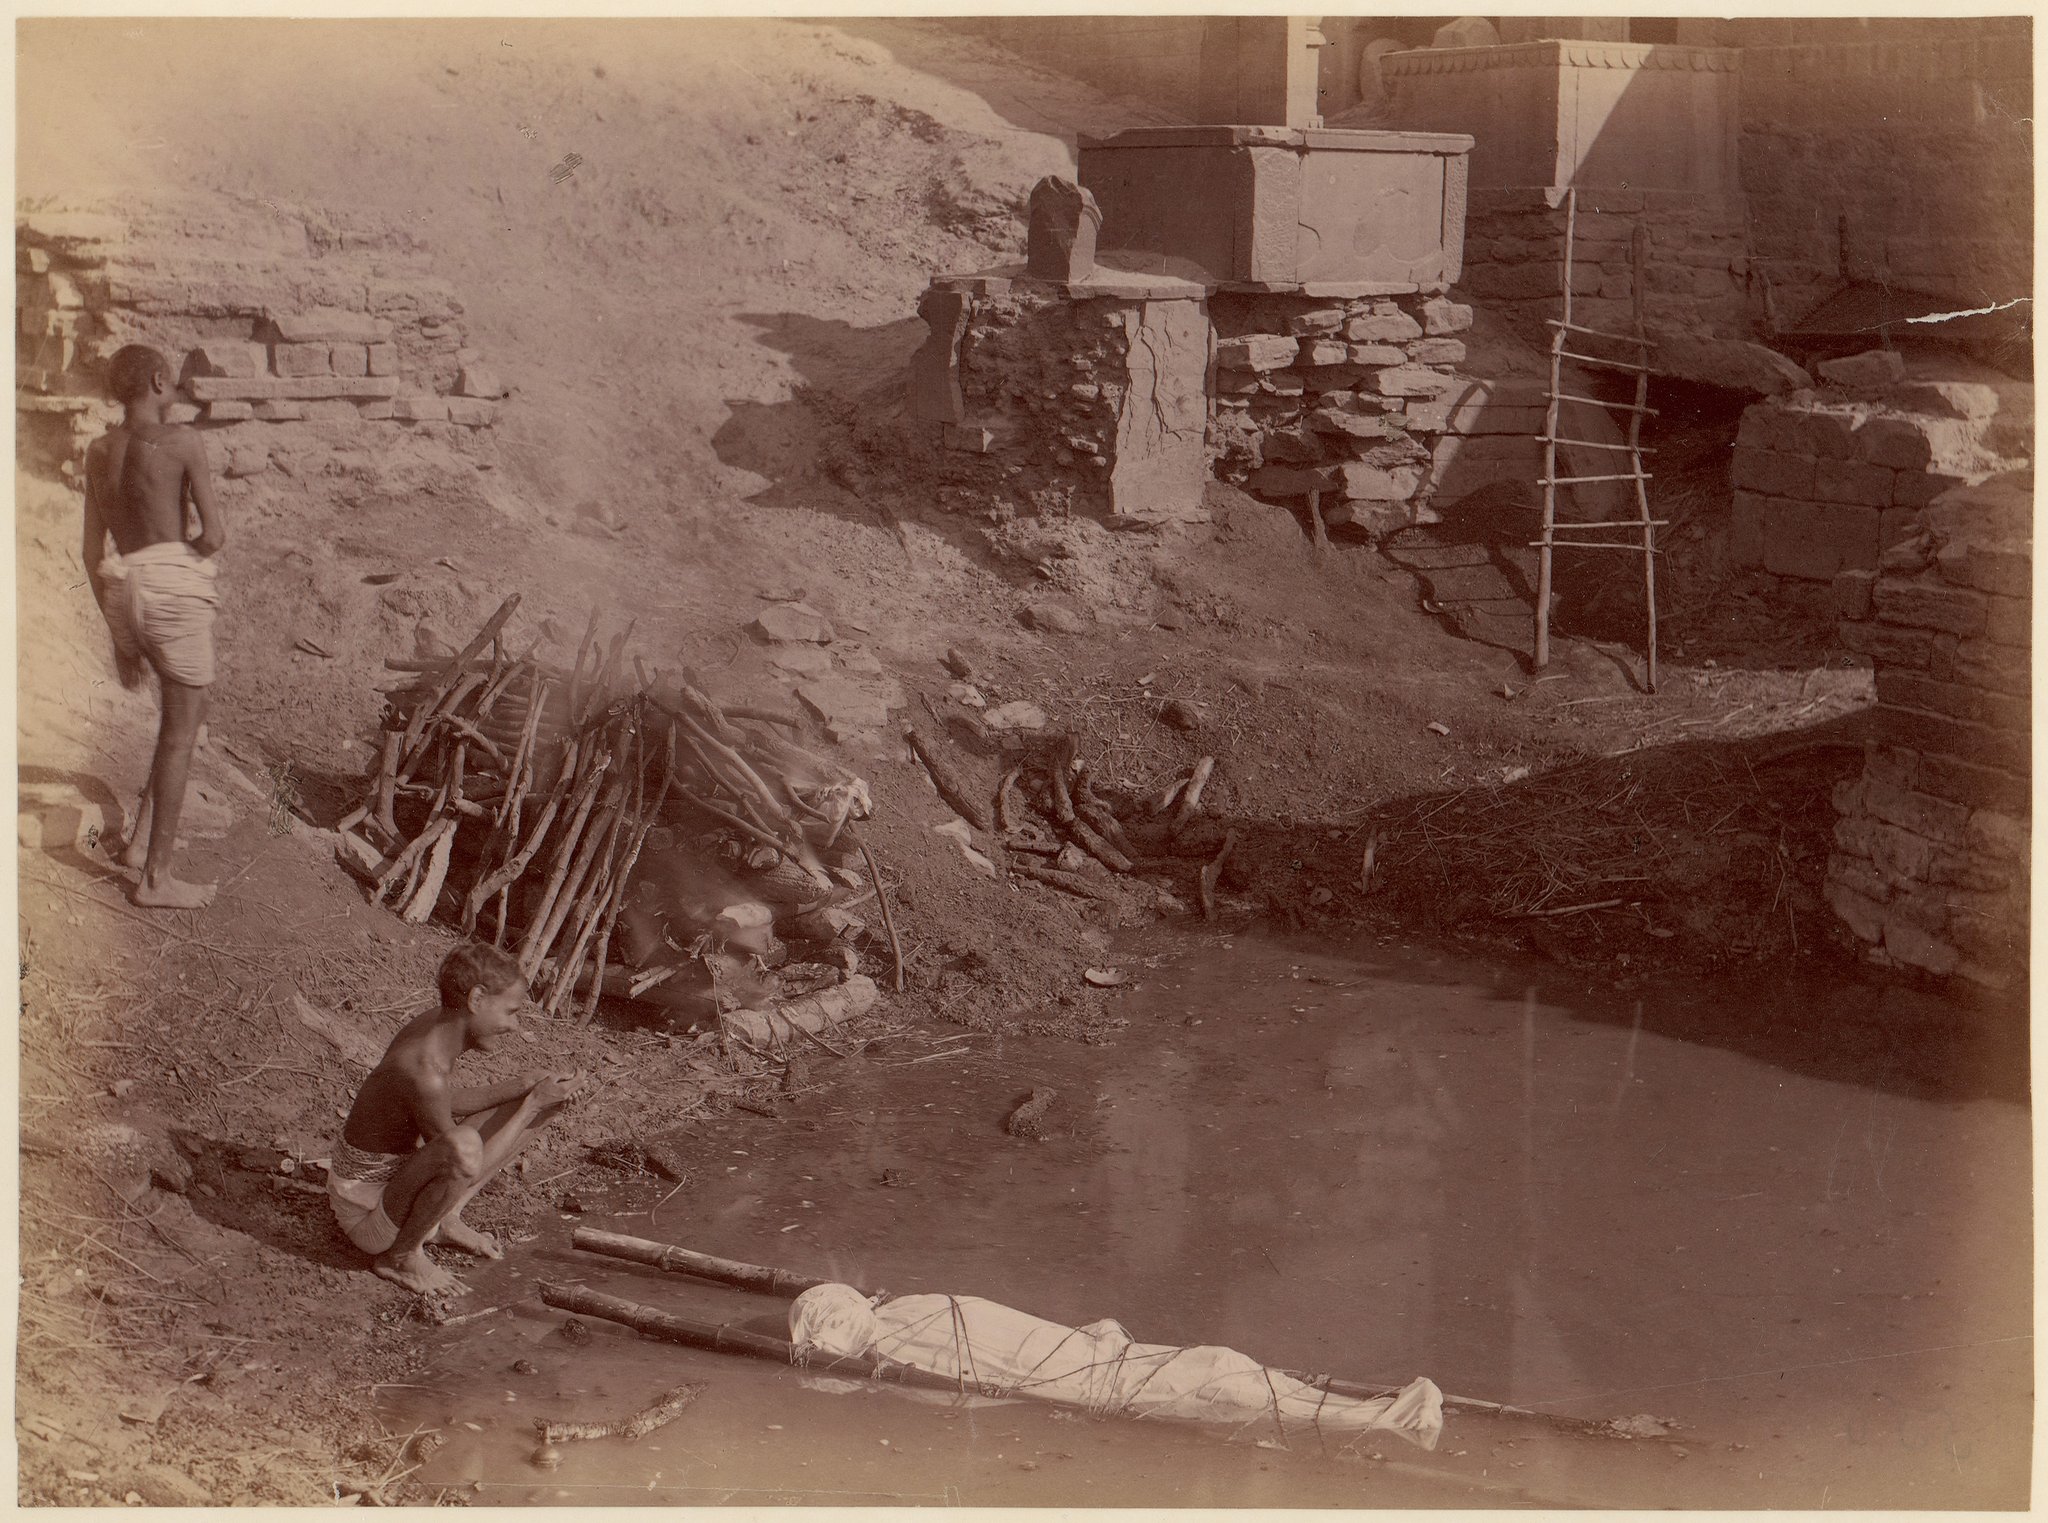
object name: photograph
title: [Cremation Ground at Manikarnika Ghat, Varanasi, India]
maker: lawrie & co., g.w.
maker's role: artist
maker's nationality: british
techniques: albumen silver print, glass negative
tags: corpses,men,death